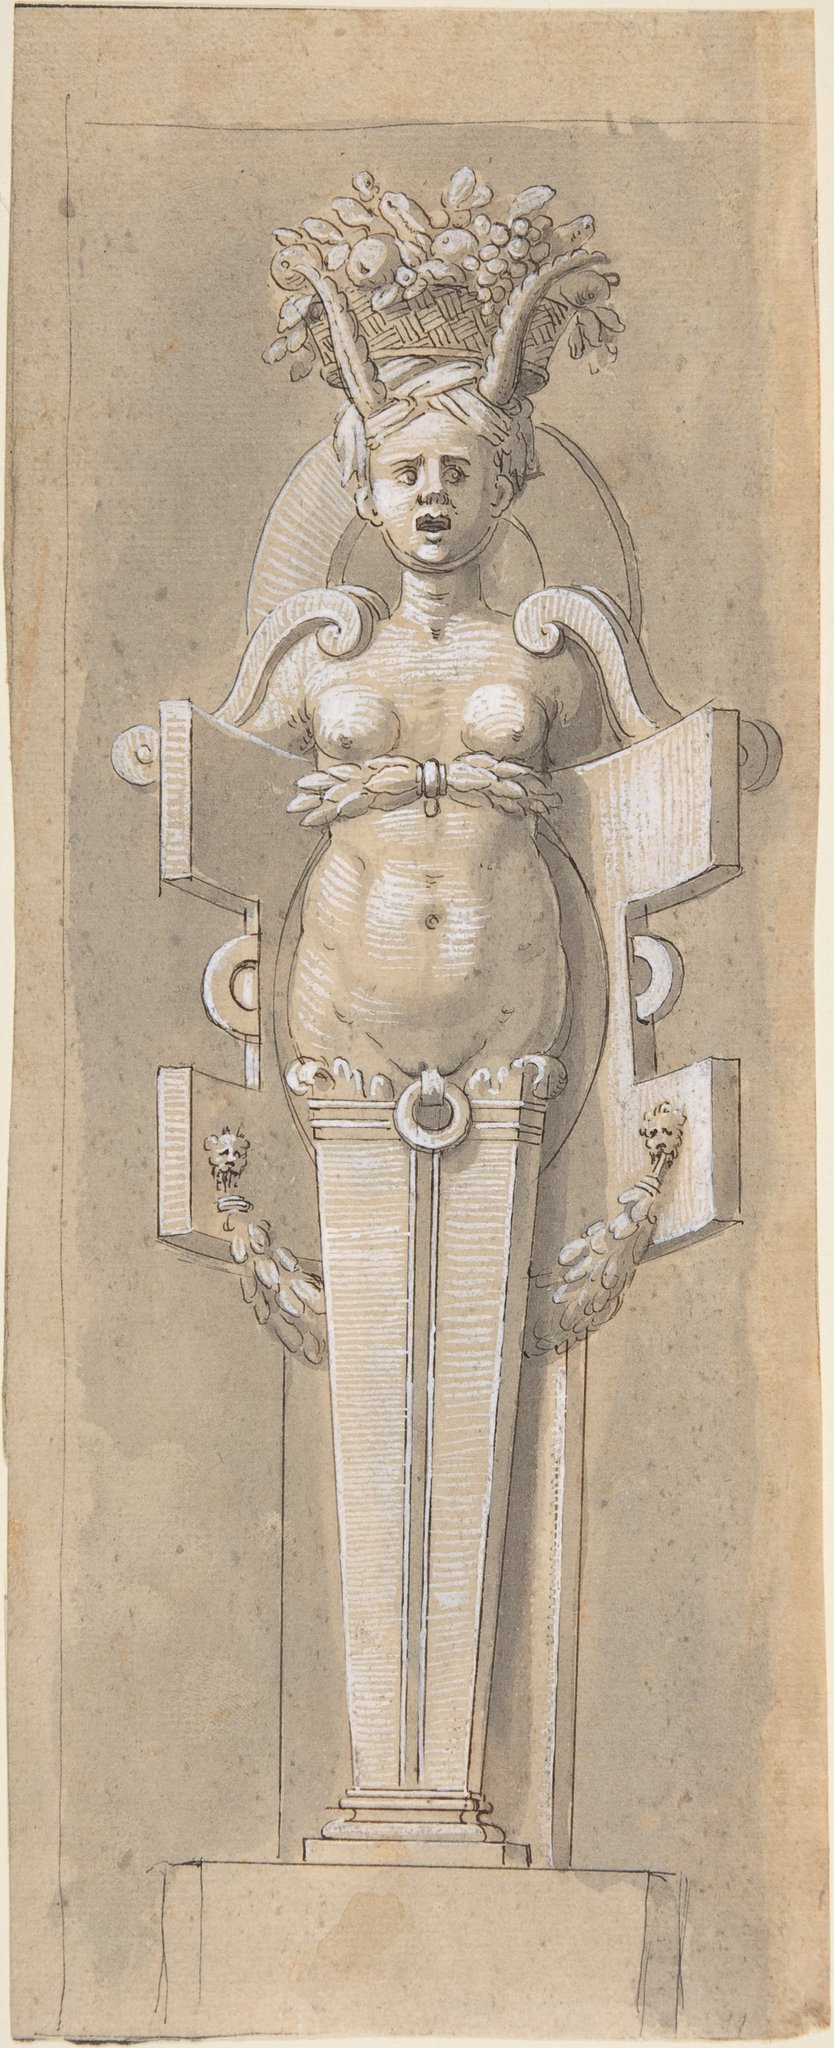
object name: drawing ornament architecture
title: Female Term encased by a Strapwork Panel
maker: anonymous, french, 16th century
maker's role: artist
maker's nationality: french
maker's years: 1500-1600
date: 1545-1565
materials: ink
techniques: heightening, pen, wash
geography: italy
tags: fruit,female nudes